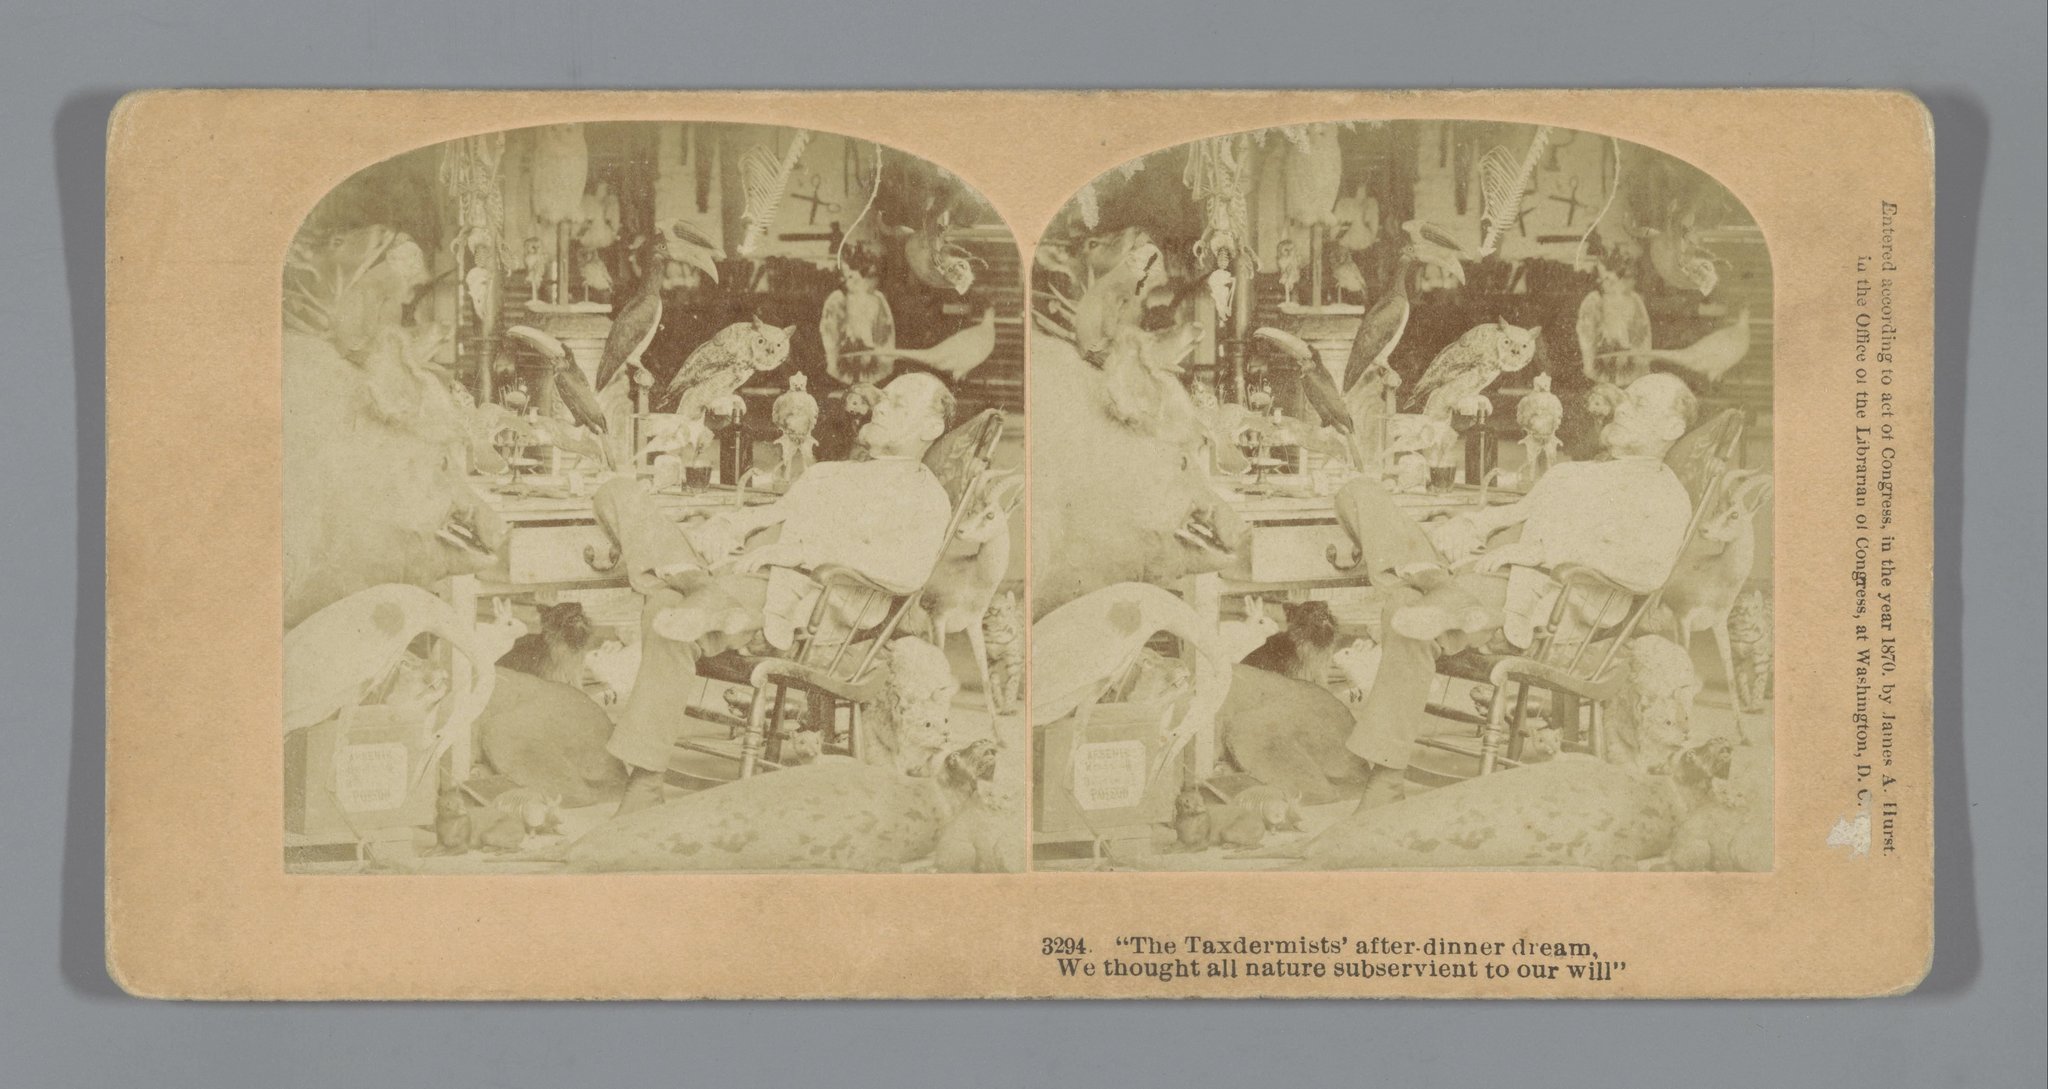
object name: stereograph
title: Man slapend in stoel te midden van opgezette dieren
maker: benjamin west kilburn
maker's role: fotograaf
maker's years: 1827-1909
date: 1870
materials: cardboard, photographic support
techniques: albumen print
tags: hoofed animals: deer, birds (+ stuffed animal)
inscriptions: number: ‘3294’, : ‘Entered according to act of Congress, in the year 1870, by James A. Hurst. / In the Office of the Librarian of Congress, at Washington, D.C.’, company name: ‘Photographed and Published by / B.W. Kilburn, Littleton, N.H.’